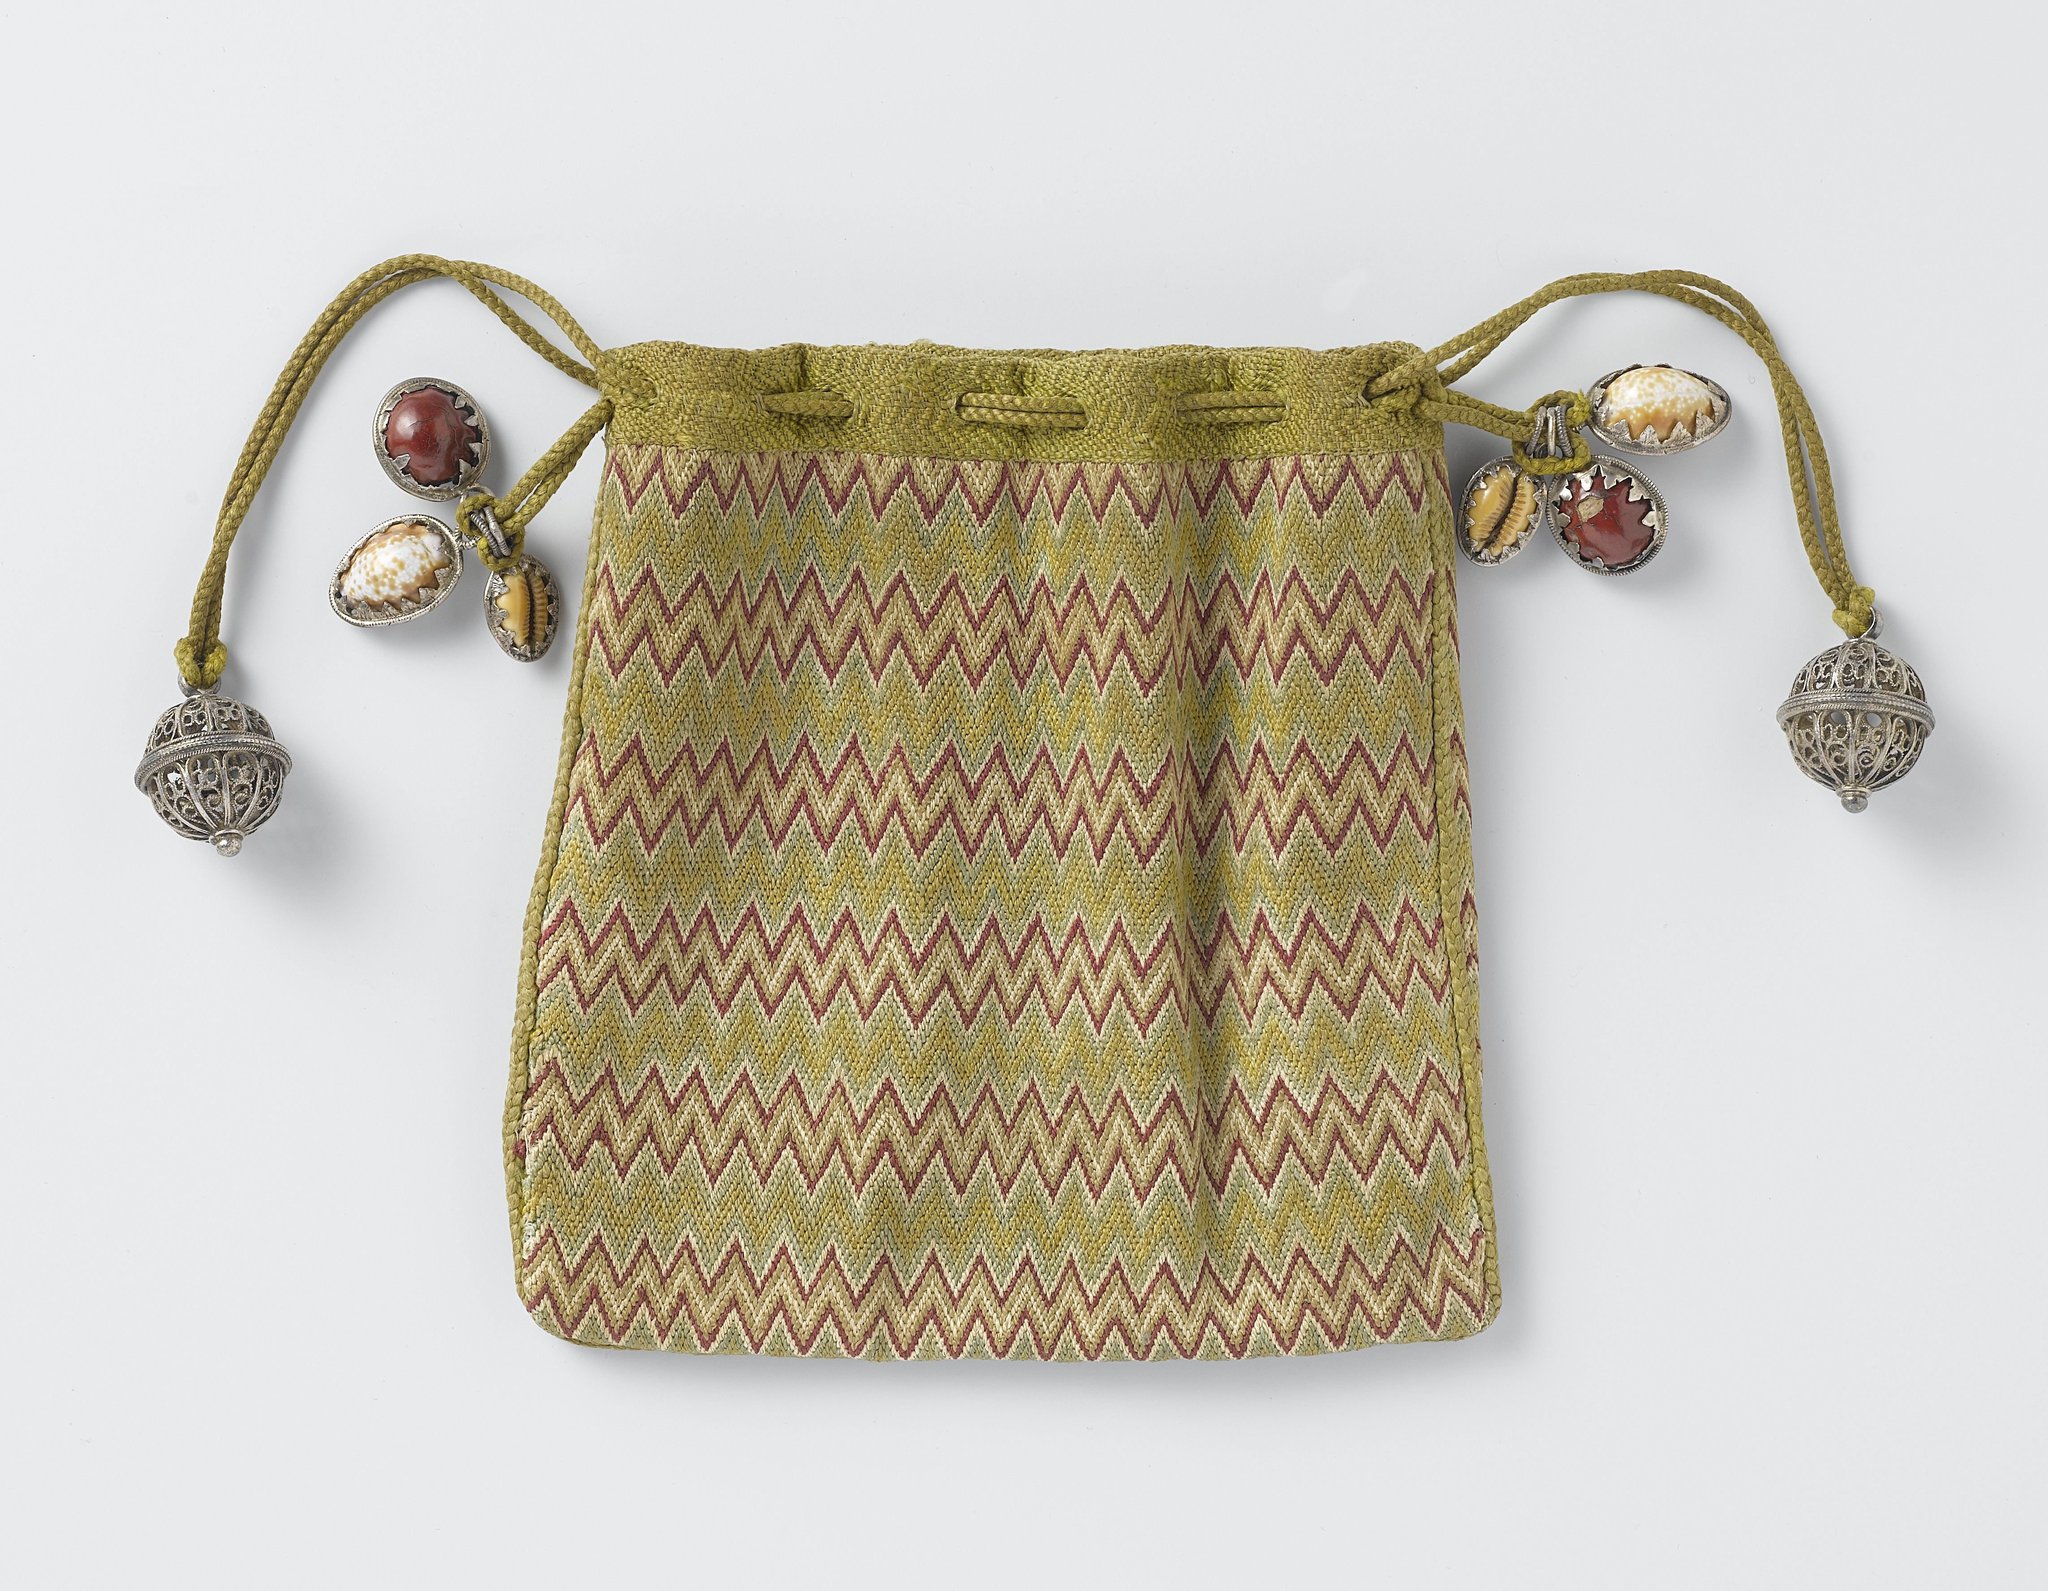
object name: knottepong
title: Buidel, geborduurd met zigzagpatroon (point d'Hongrie) in groene, witte en roodbruine zijde met trekkoord voorzien van zilveren pommanders, in zilver gevatte schelpen en 'bezoar'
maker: Anonymous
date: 1675-1700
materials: shell, silk, silver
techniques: embroidery, braiding, embroidered, forging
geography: friesland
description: Tas, zijde, floszijde: point d’Hongrie borduurwerk, zilveren pomanders of reukbollen, schelpen en bezoar (steen uit de maag en het darmkanaal van herkauwers) in zilveren zetting Nederland, ca. 1675-1700 Inv. BK-NM-8535 Reukbollen werden gevuld met geurende kruiden en bloemblaadjes. De bezoar zou geneeskrachtige eigenschappen hebben.